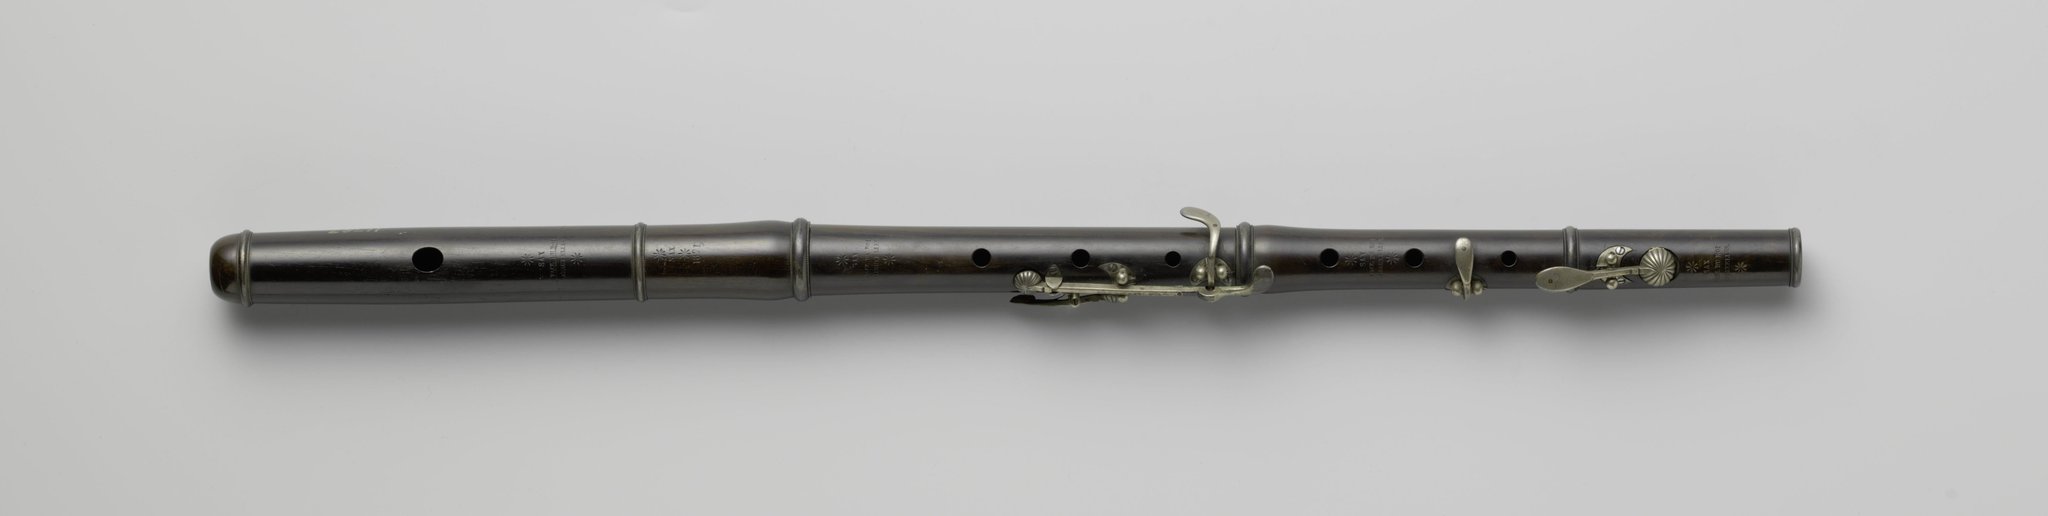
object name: flute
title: Third flute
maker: charles joseph sax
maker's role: musical instrument maker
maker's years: 1790-1865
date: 1821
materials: wood, mother of pearl, silver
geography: brussels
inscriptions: stamp: ‘SAX/FACr. DU ROI / A BRUXELLES’, stamp: ‘SAX/ 1821’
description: Terts dwarsfluit van ebbenhout met zilveren beslag, met twaalf gaten en vijf kleppen. Adres (ingedrukte letters tussen twee sterren): SAX (FACr DU ROI) A BRUXELLES (viermaal); SAX met twee sterren en het jaartal 1821. Tertsfluit.